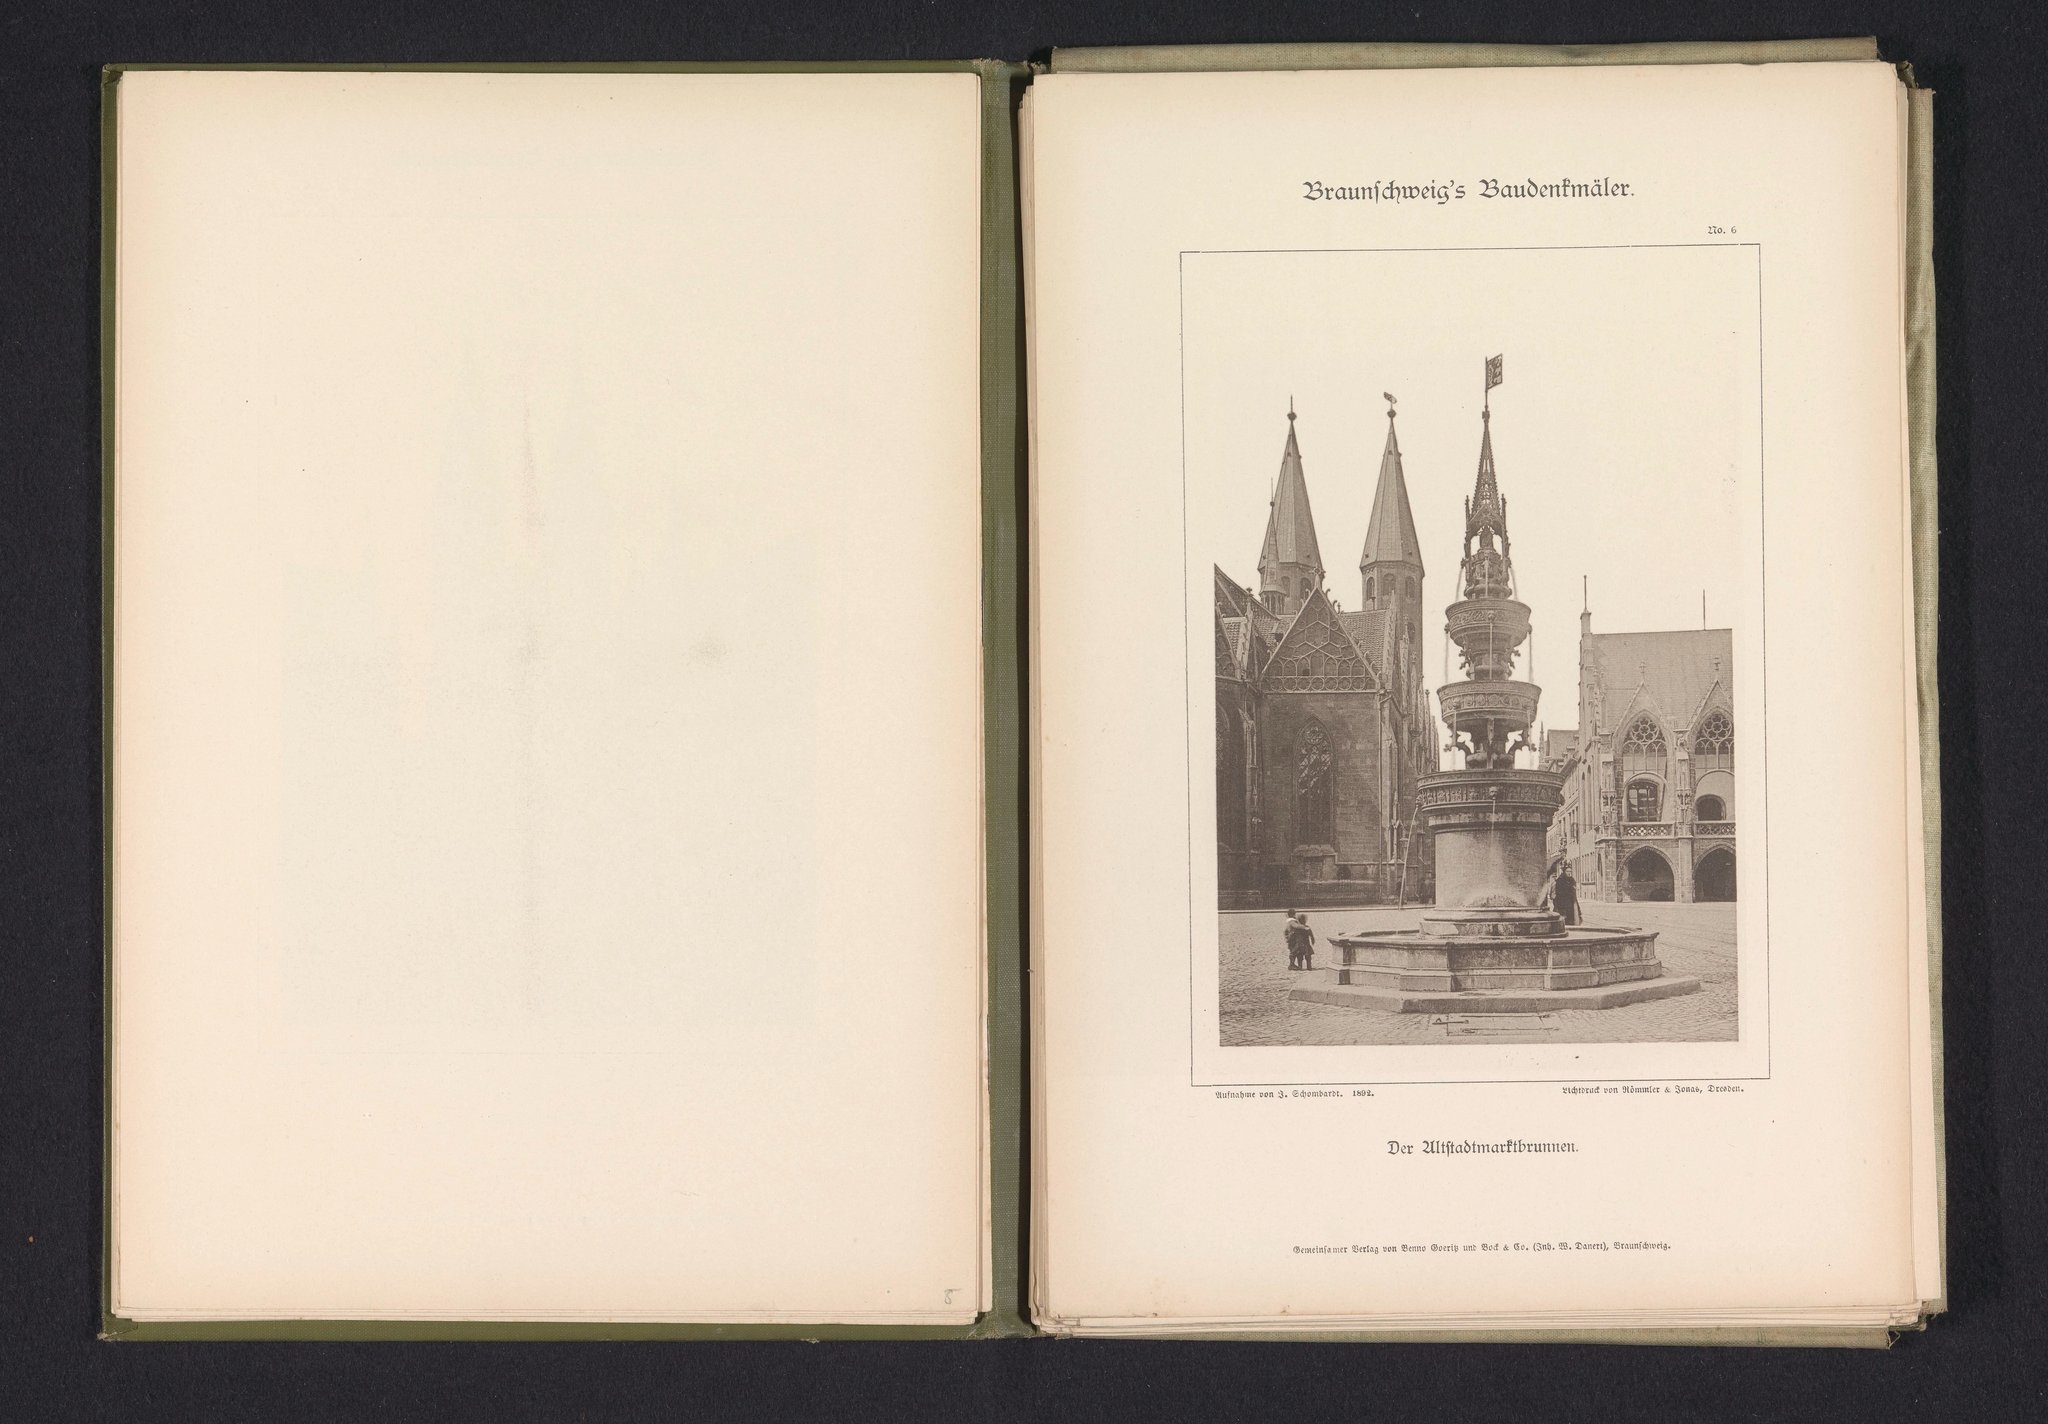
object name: photomechanical print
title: Braunschweig's Baudenkmäler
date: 1892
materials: paper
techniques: photograph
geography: braunschweig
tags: ornamental fountain, village square, place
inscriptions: number: ‘No. 6.’